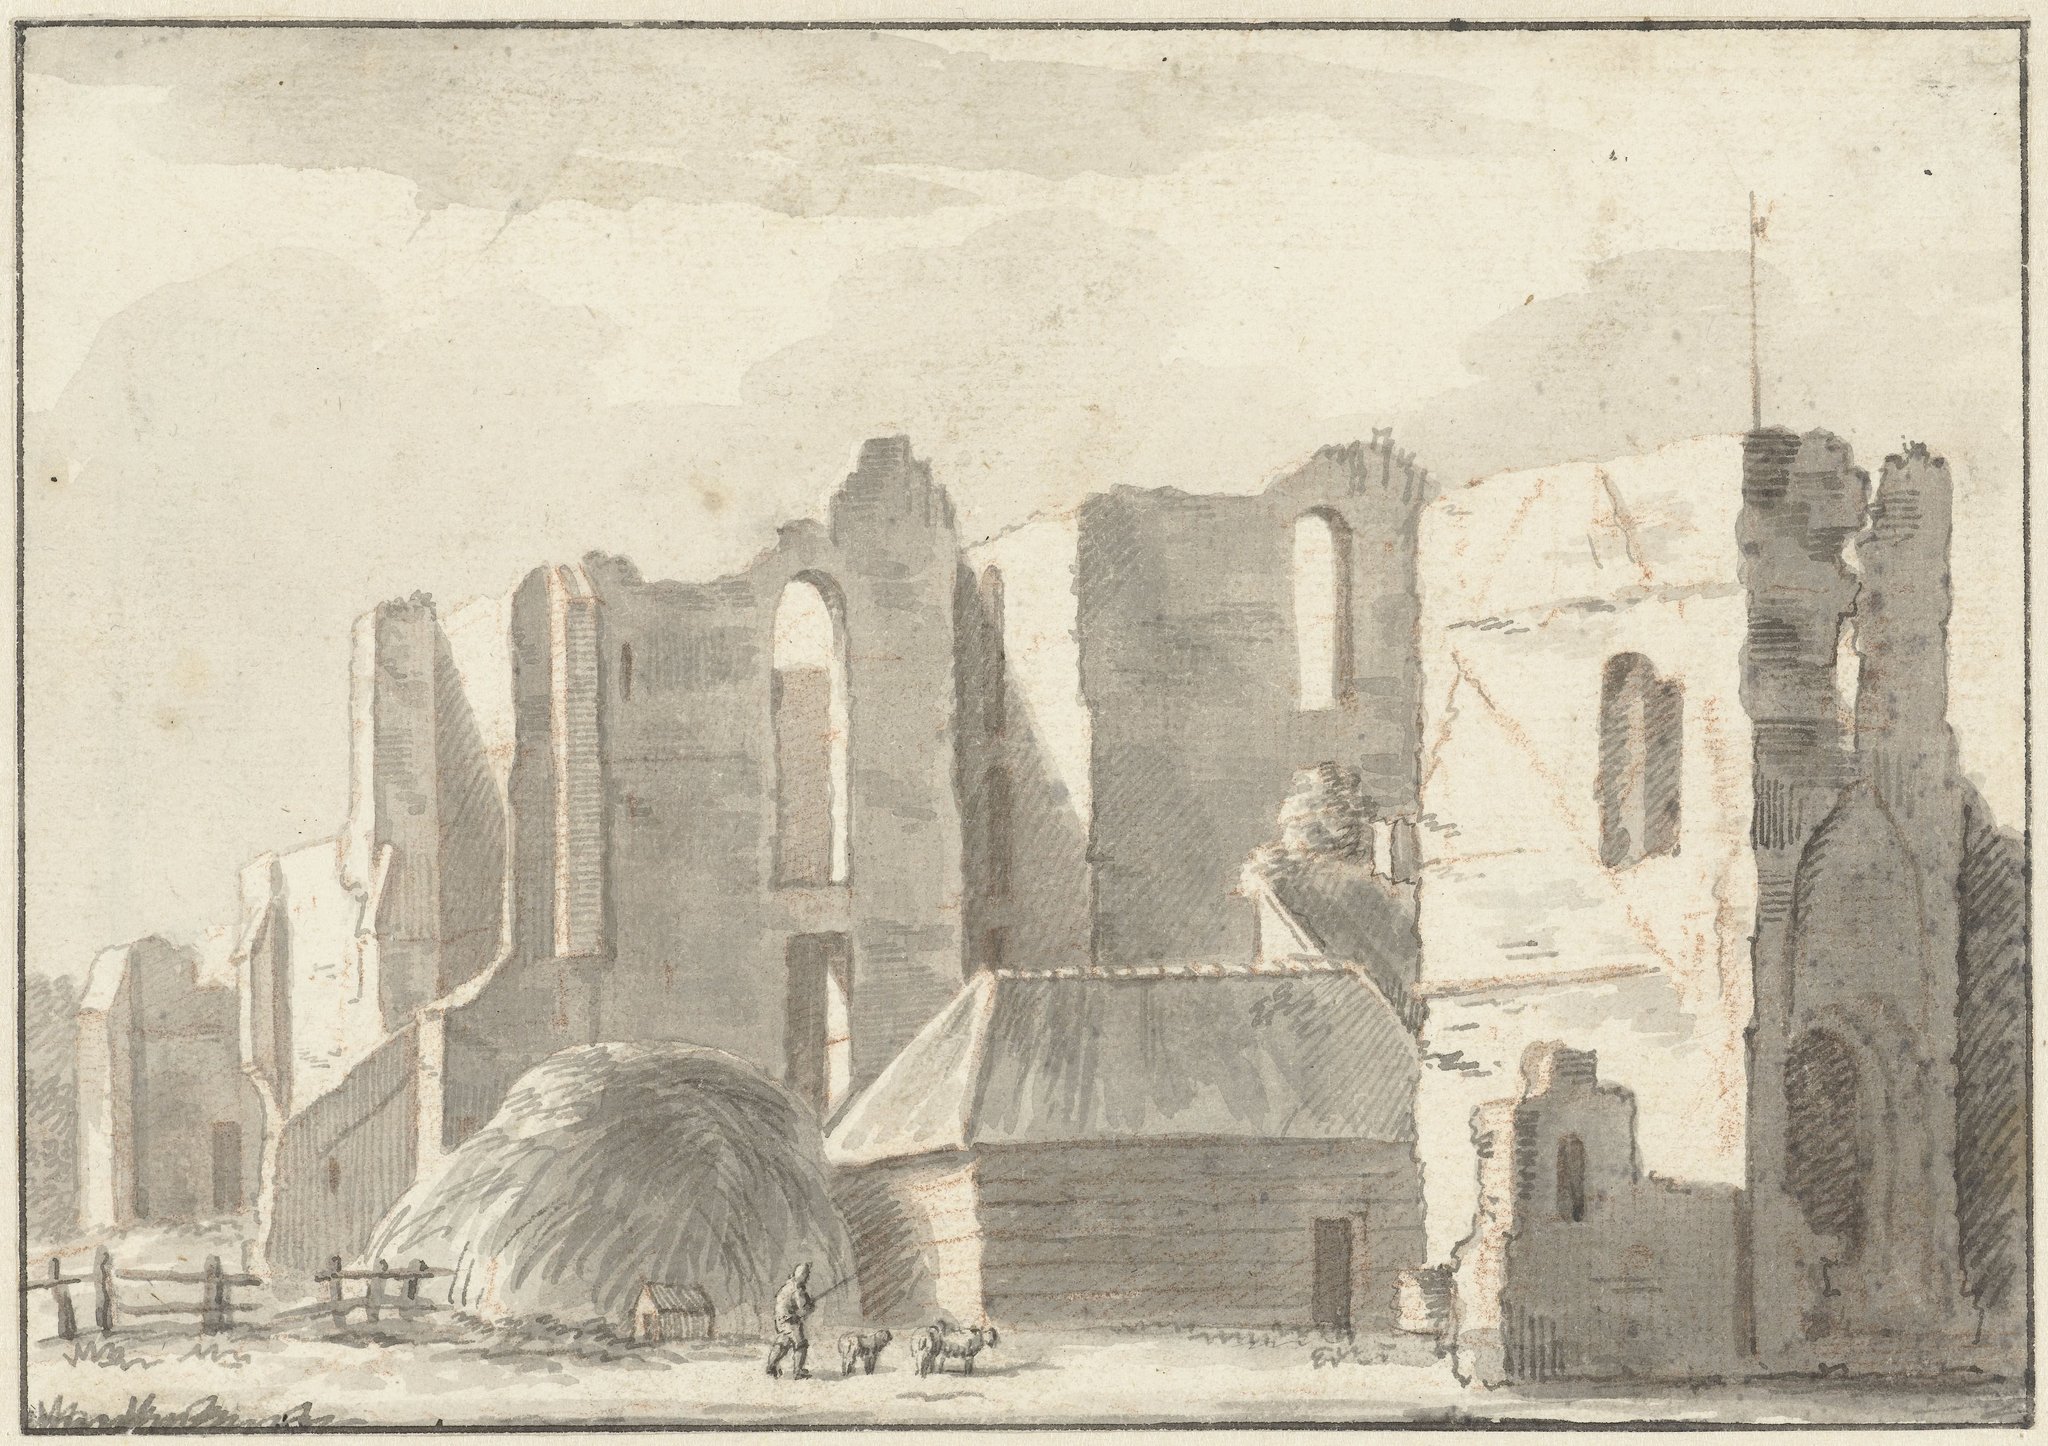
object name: drawing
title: Ruïne van kasteel Brederode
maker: abraham de haen (ii)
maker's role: draughtsman, print maker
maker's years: 1707-1748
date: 1717-1748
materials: chalk, ink, paper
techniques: brush, pen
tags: ruin of a dwelling, house, castle, etc.